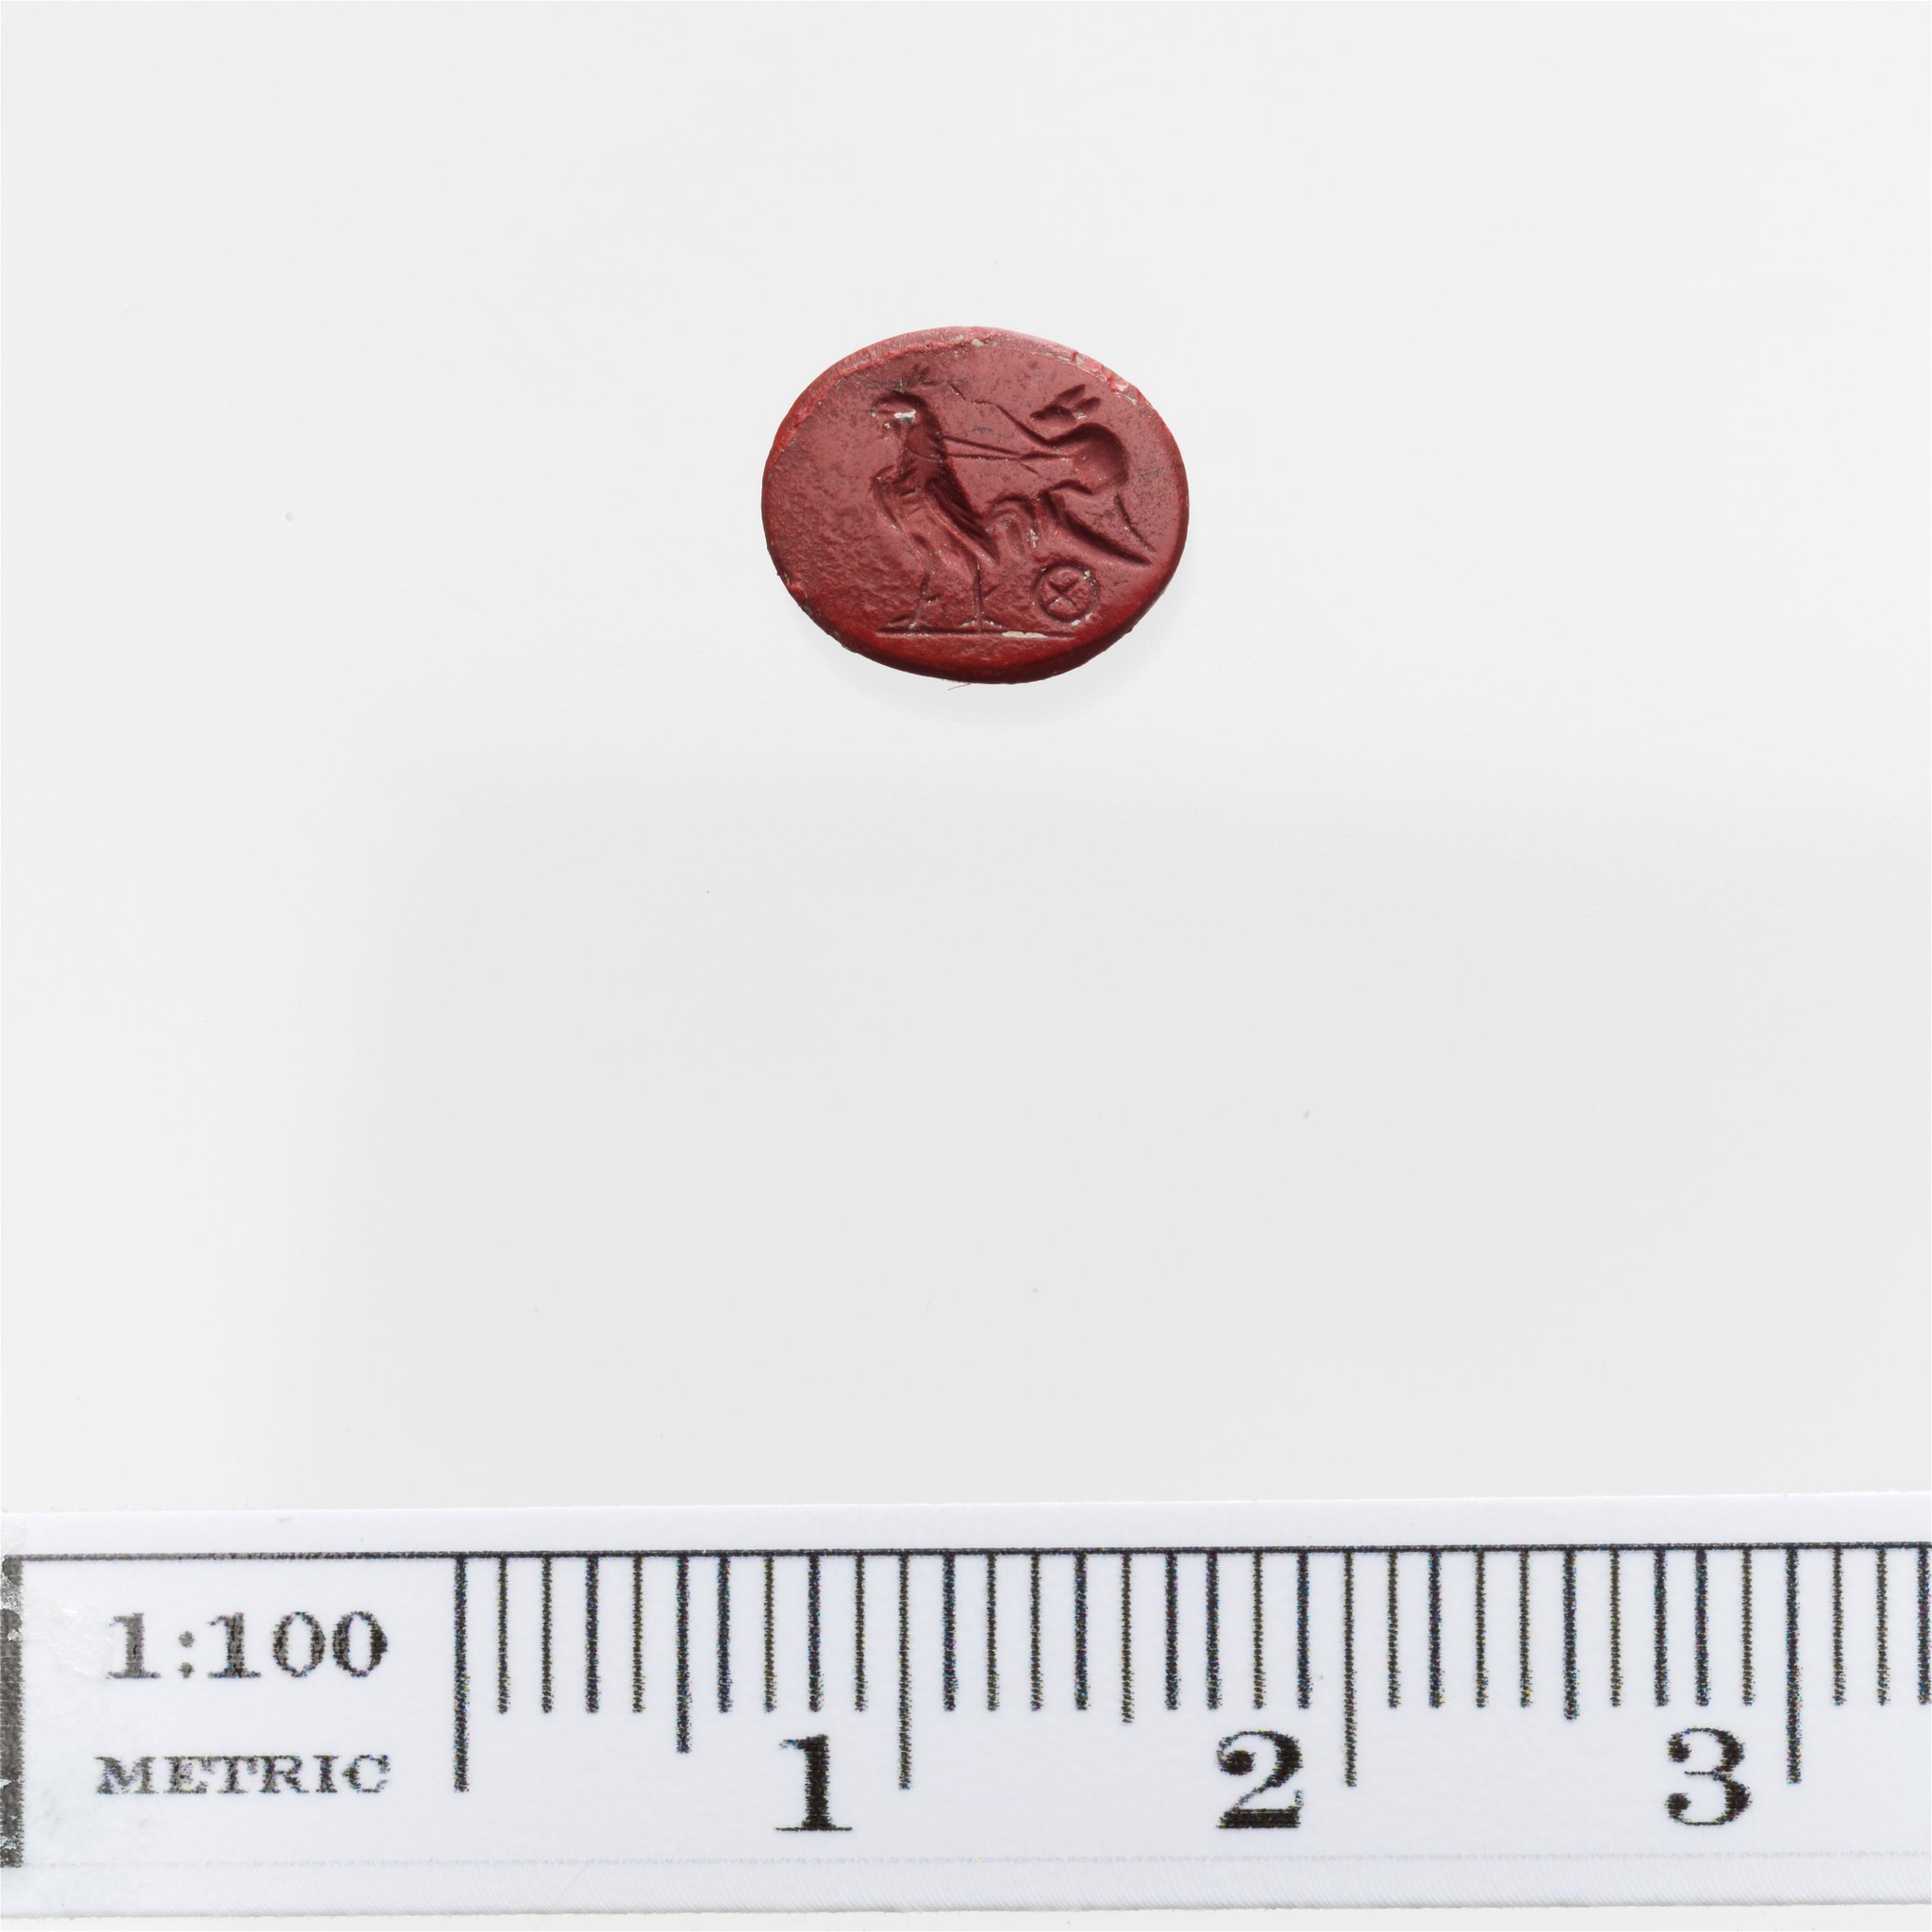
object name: intaglio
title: Jasper ring stone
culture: roman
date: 101-200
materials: jasper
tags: roosters,mice,chariots